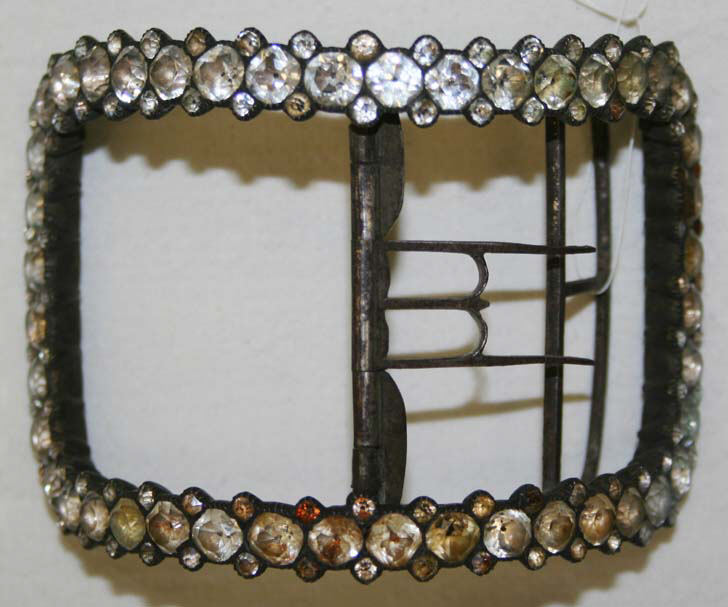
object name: shoe buckle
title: Shoe buckles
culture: british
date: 1767-1800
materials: paste, silver, steel